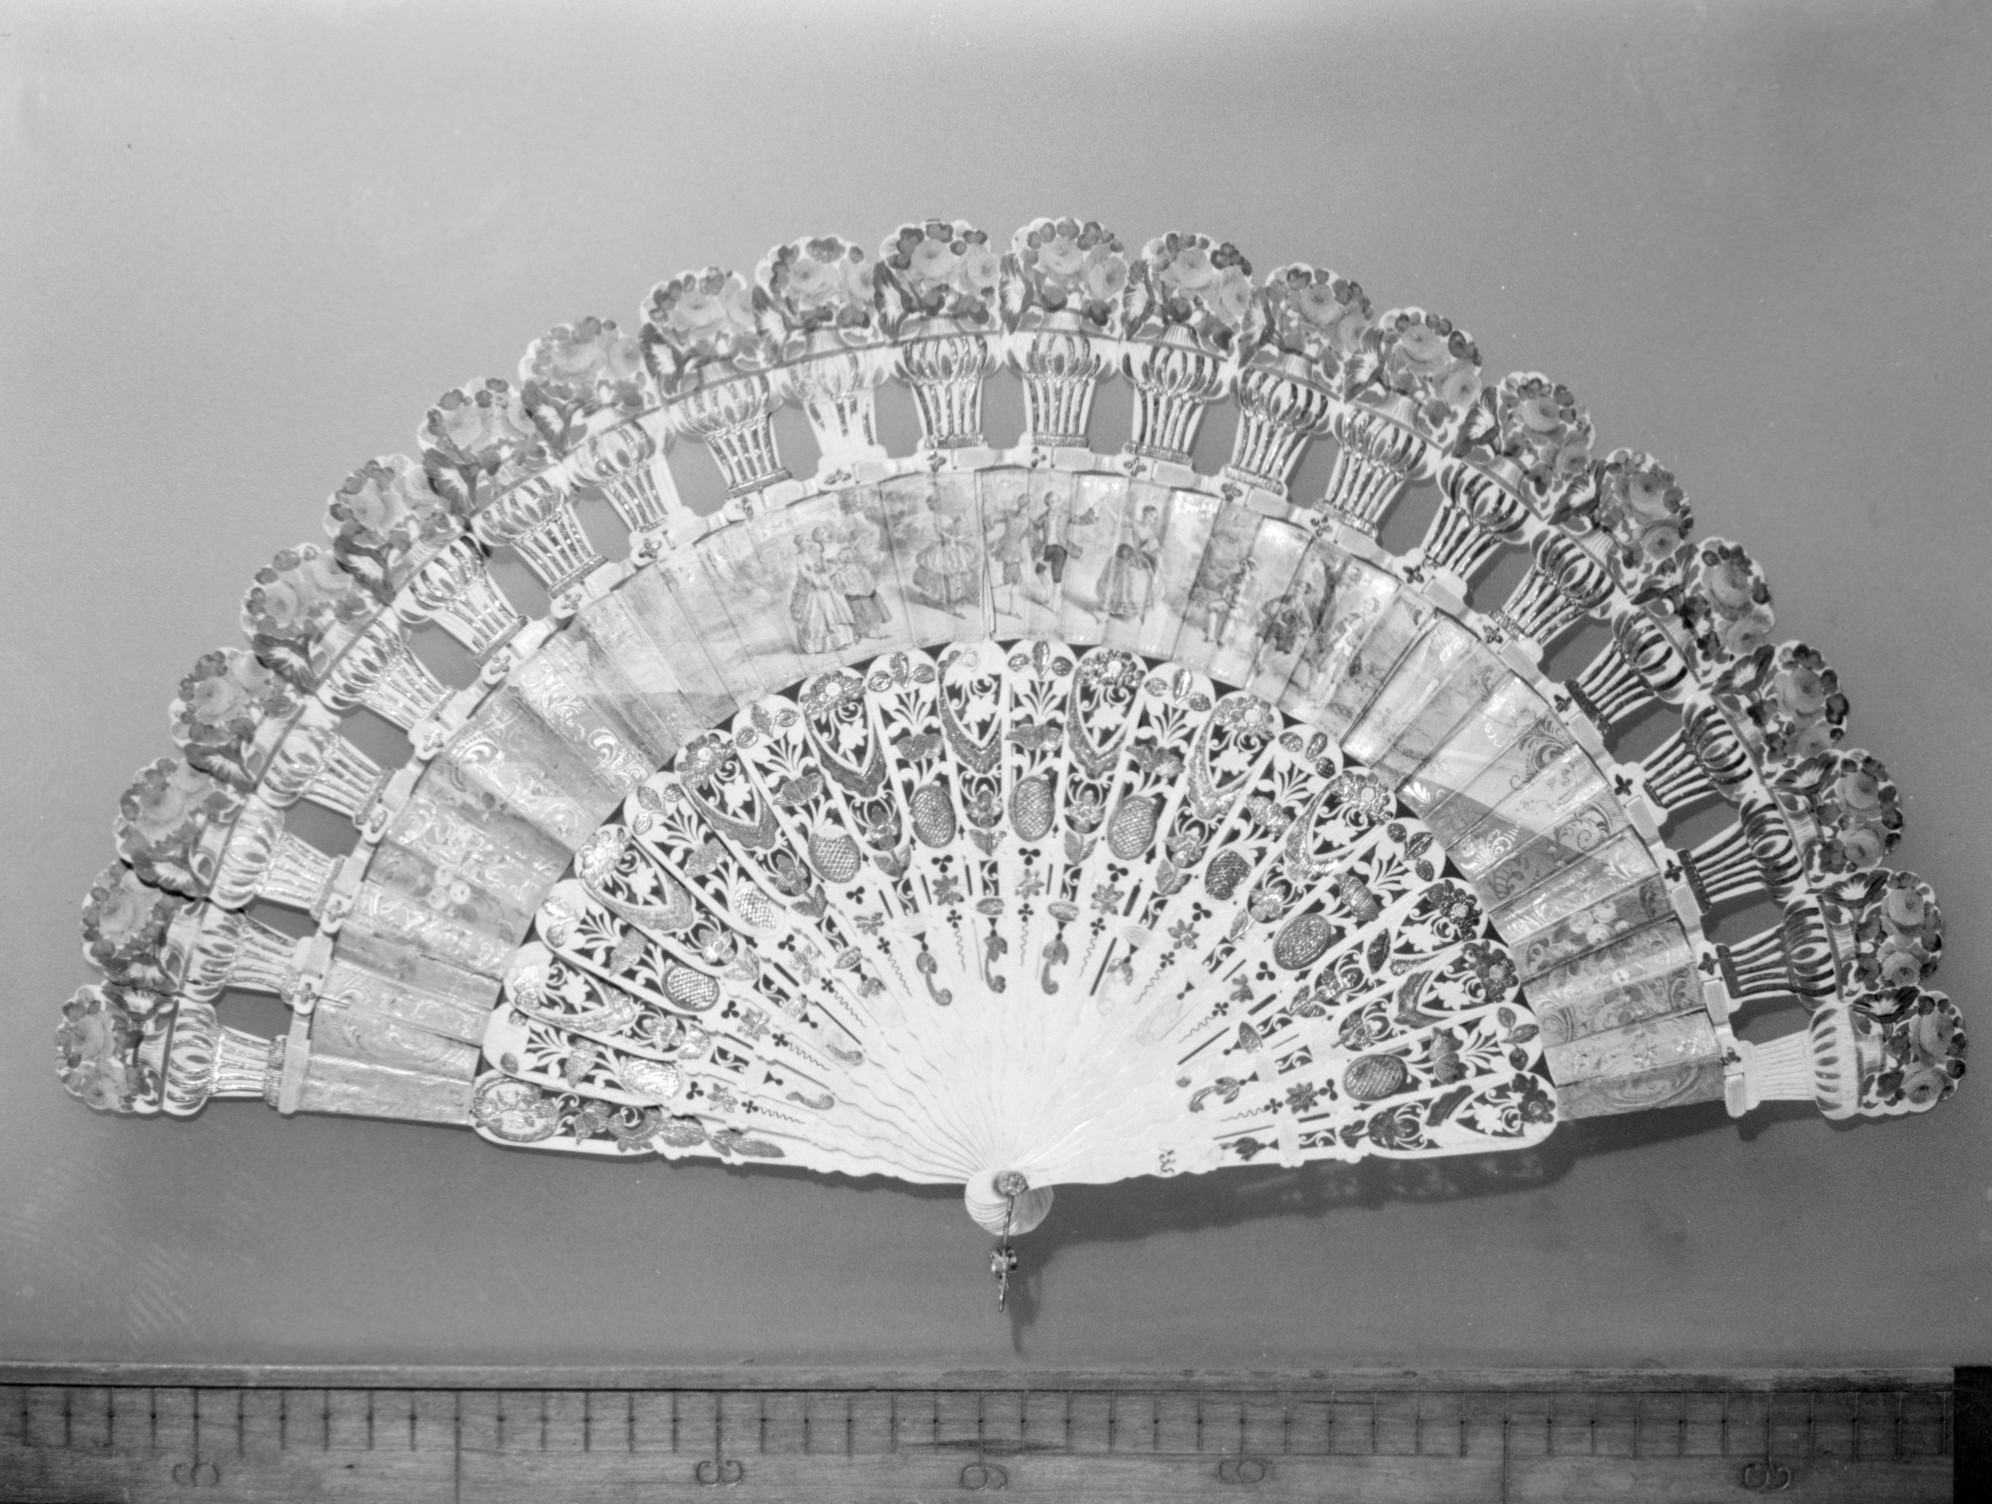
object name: fan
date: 1834-1866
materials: gilt, ivory, paper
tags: men,women,dancing